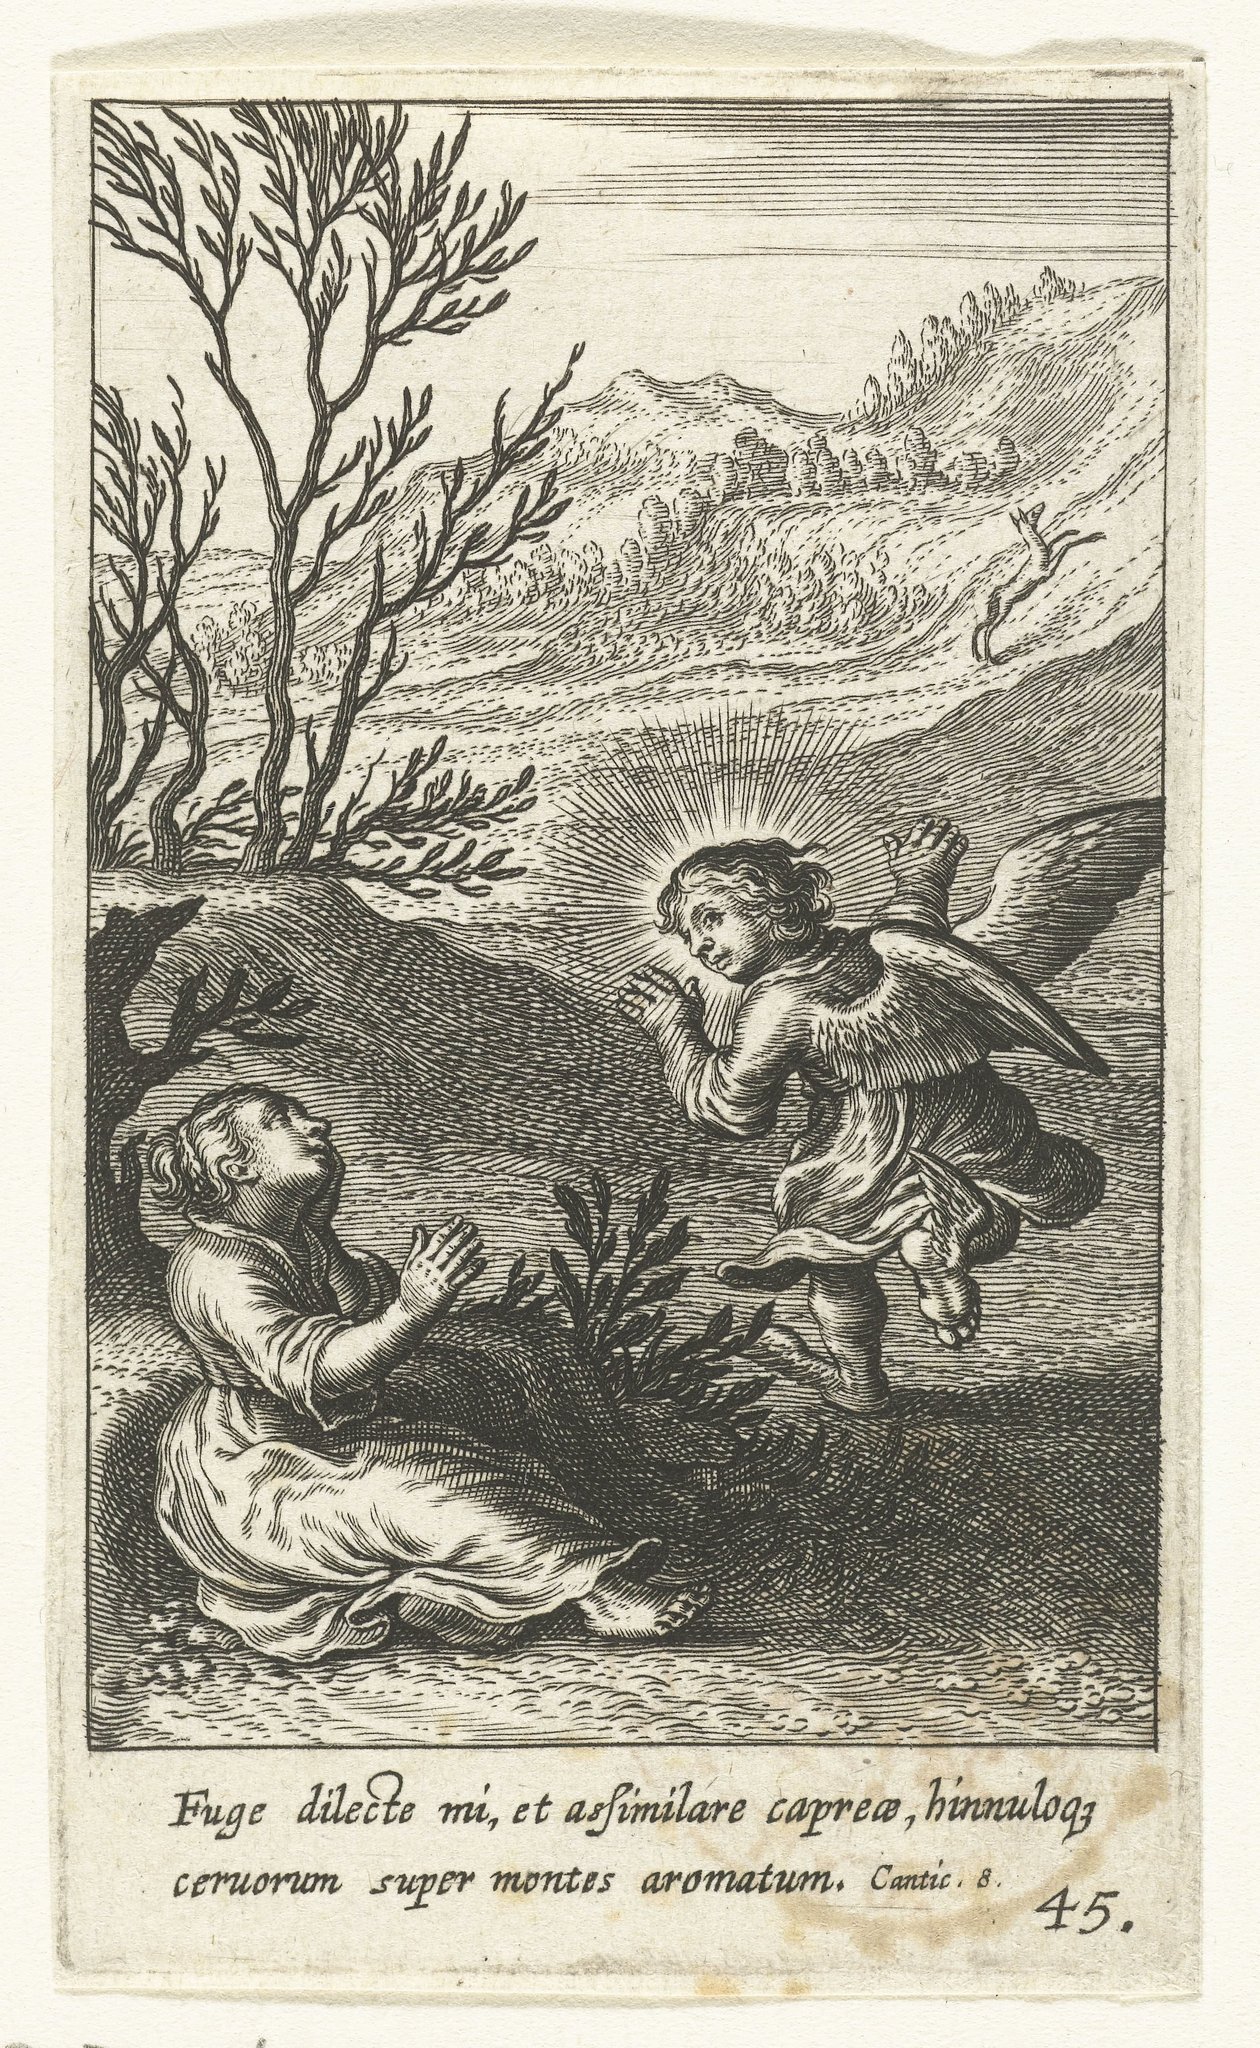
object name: book illustration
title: Pia desideria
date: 1590-1624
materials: paper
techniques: engraving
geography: antwerp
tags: flight, running away; pursuing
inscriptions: inscription: ‘Fuge dilecte mi, et assimilare capreæ hinnuloq; ceruorum super montes aromatum.’, collector's mark: Lugt 240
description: Boekillustratie uit: Herman Hugo, Pia desideria emblematis, elegiis & affectibus S. S. Patrum illustrata, Antwerpen 1624, afb. 45